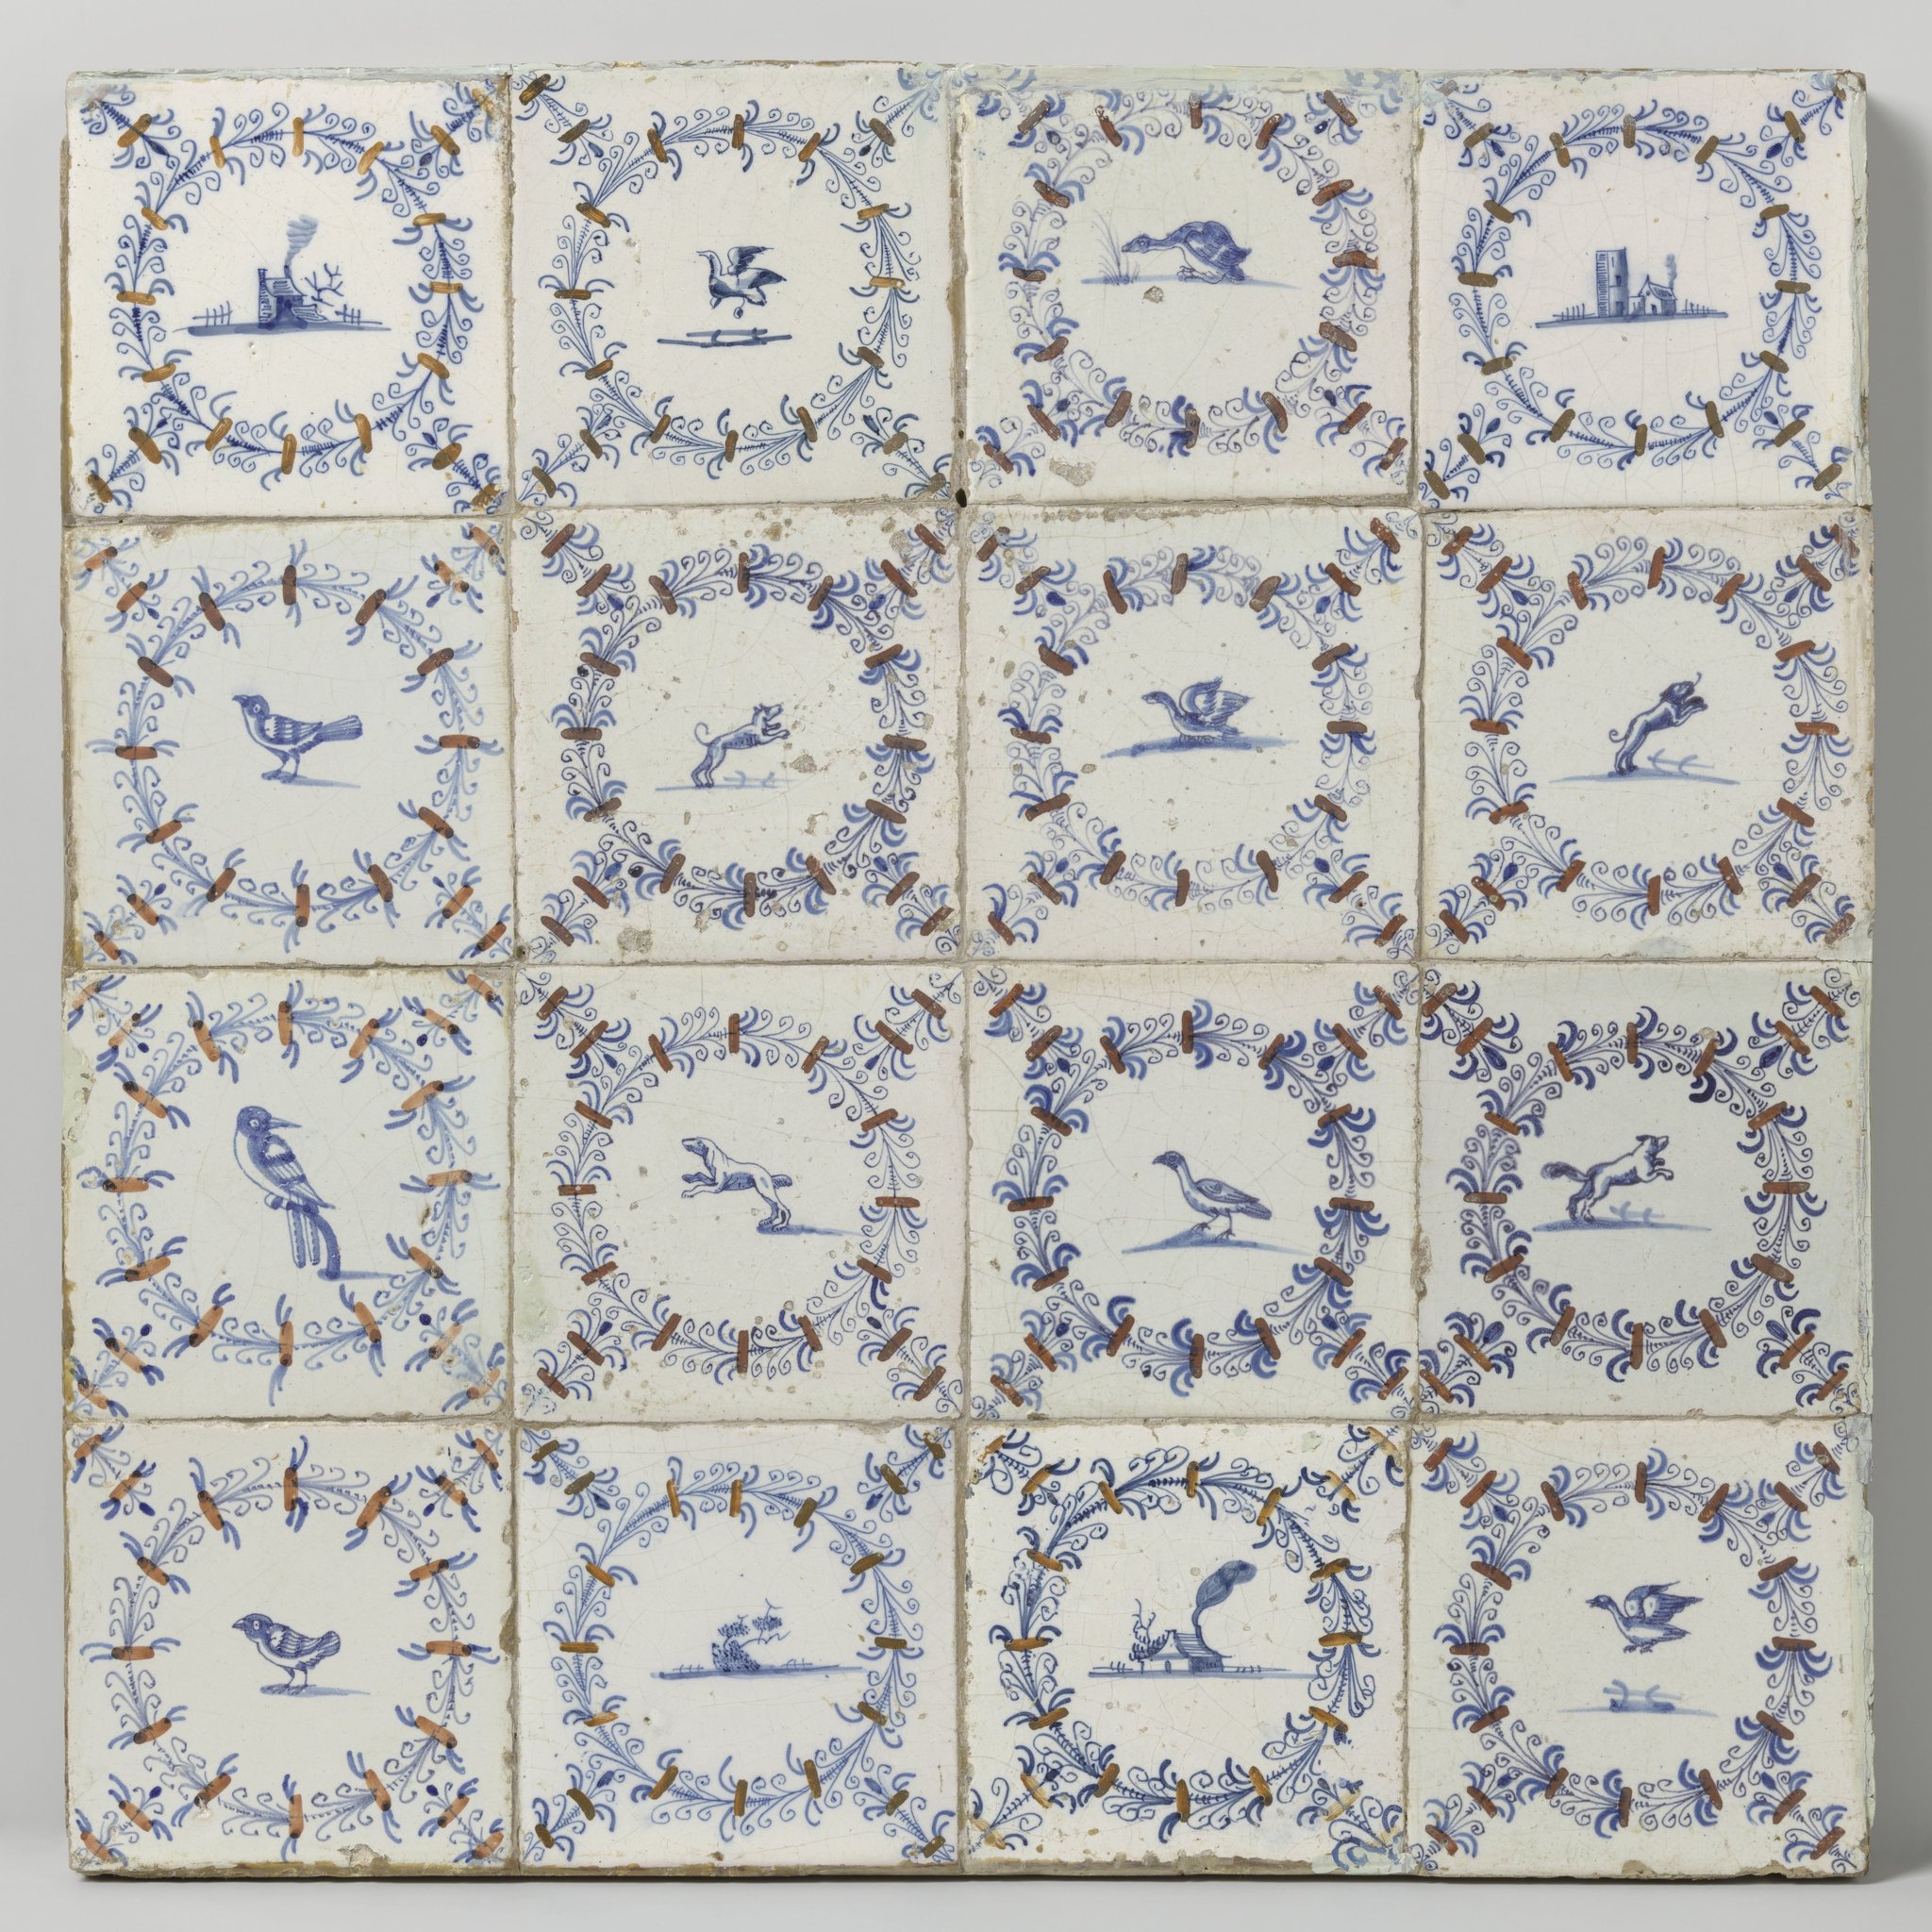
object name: tile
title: Veld van zestien tegels met dieren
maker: Anonymous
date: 1640-1660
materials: earthenware, glaze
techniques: maiolica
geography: netherlands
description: Veld van zestien tegels (4 x 4) elk met een veelkleurig (blauw en bruinoranje) dier binnen een krans met veertoef.